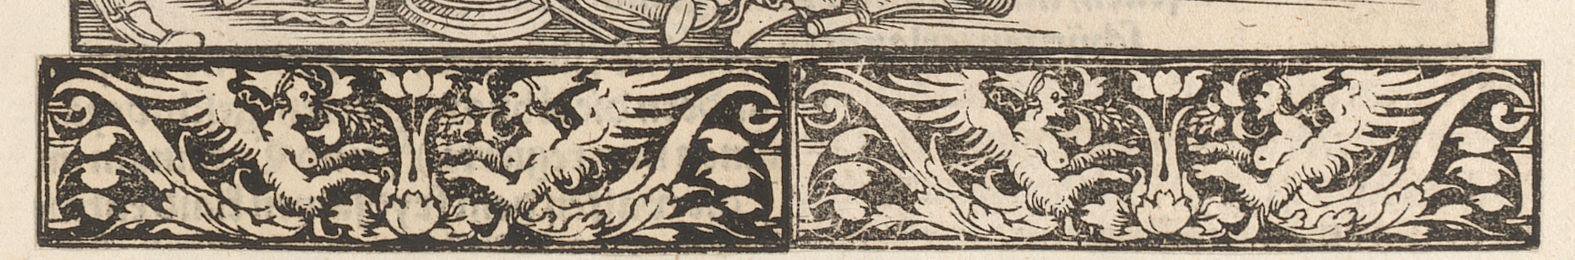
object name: print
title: Twee sfinxen en ornamenten met bladmotief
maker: Anonymous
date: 1514-1532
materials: paper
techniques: letterpress printing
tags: sphinx (lion/woman); 'sfinge' (ripa), foliage, tendrils, branches ~ ornament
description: Deze prent is gebruikt als ornament in: Petrarca, Francesco. Von der Artzney bayder Glück, des guten und widerwertigen: unnd weß sich ain yeder inn Gelück und Unglück halten sol (...). Augsburg: Heinrich Steiner, 1532. Deze uitgave is ook bekend onder de titel 'Trostspiegel in Glück und Unglück'.